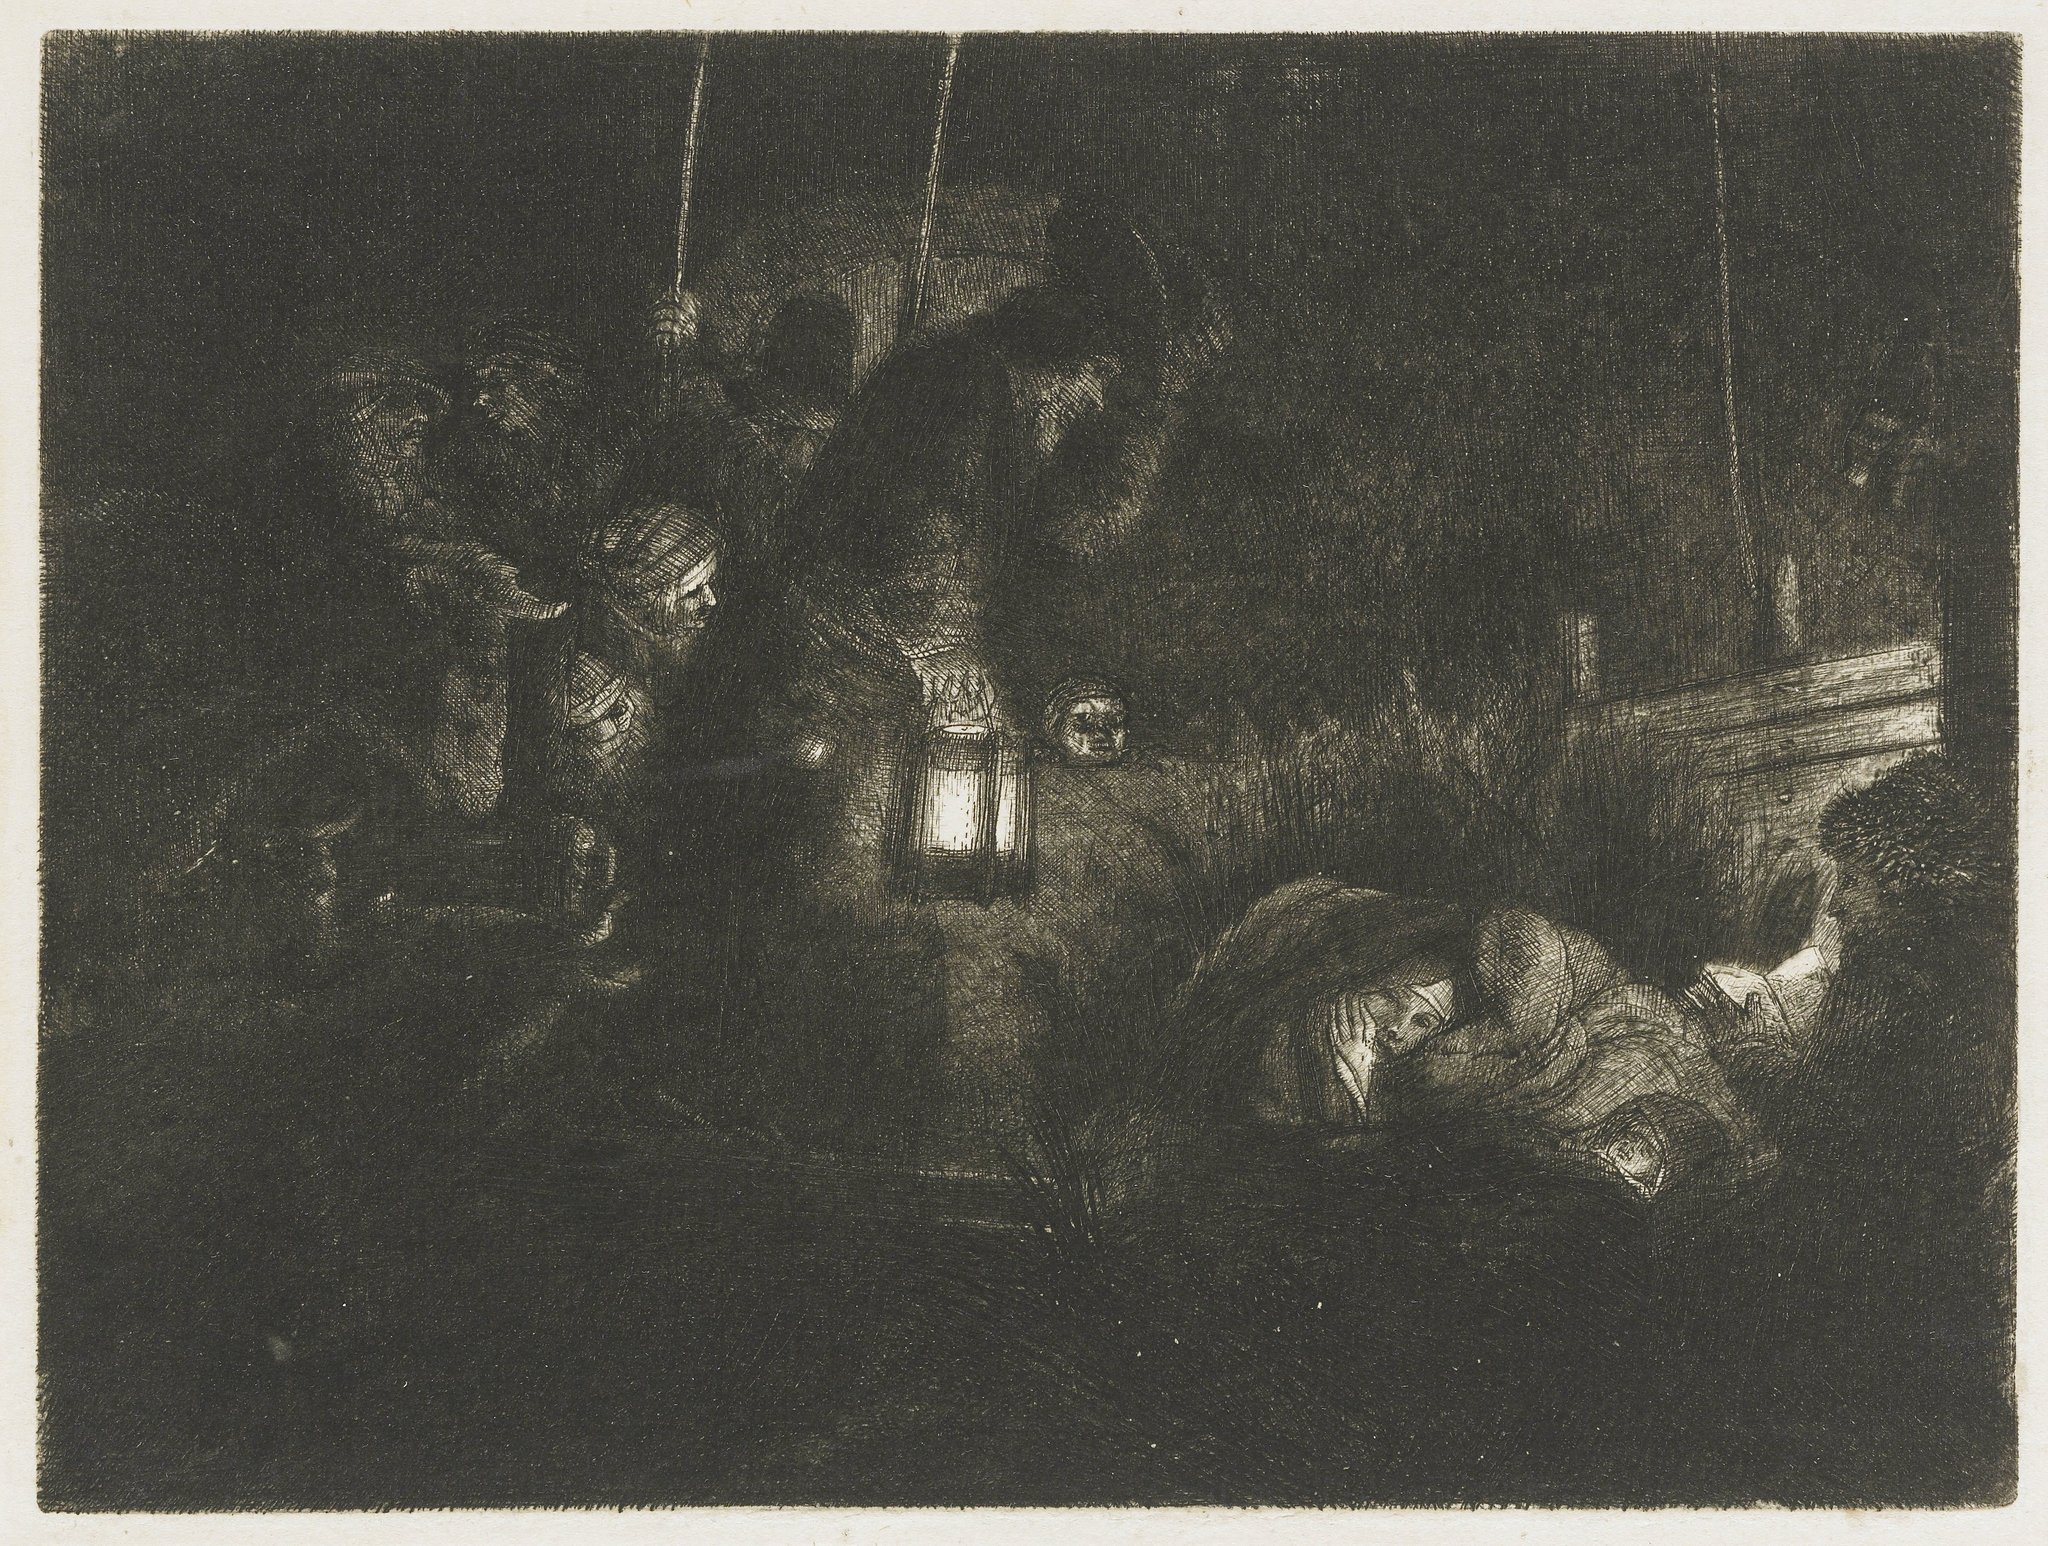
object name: print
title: The adoration of the shepherds: a night piece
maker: rembrandt van rijn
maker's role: draughtsman, painter, print maker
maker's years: 1606-1669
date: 1657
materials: paper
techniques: drypoint, etching, intaglio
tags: adoration of the christ-child by the shepherds; mary and joseph present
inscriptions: collector's mark: Lugt 240